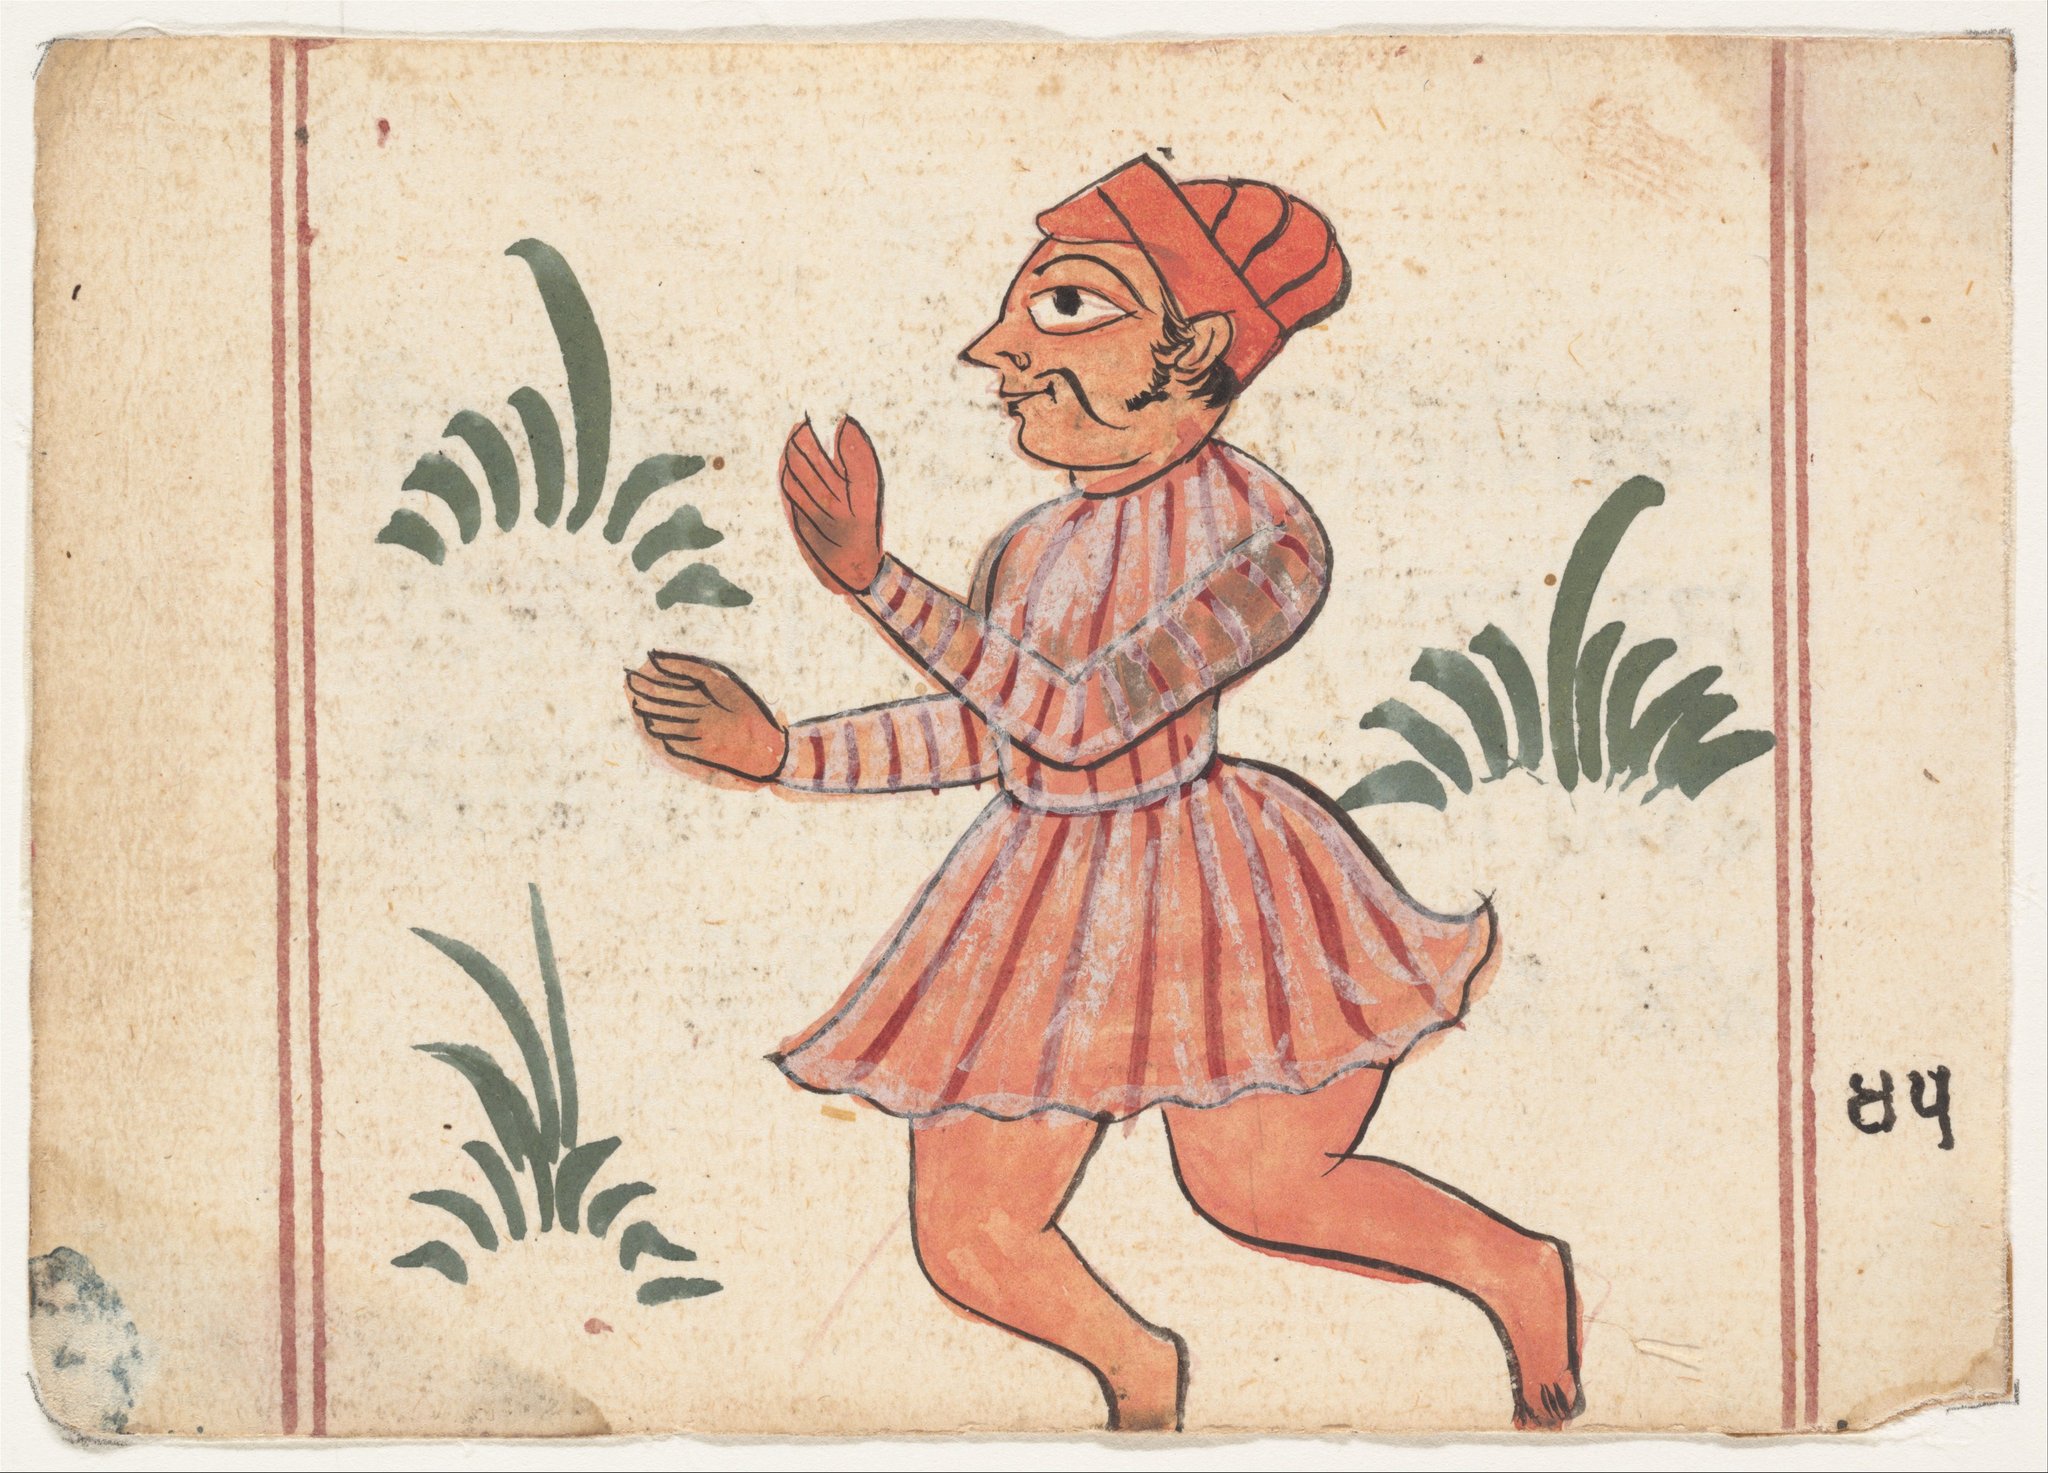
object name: folio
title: Page from a Book of Omens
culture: indian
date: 1800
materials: ink, paper, watercolor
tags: men